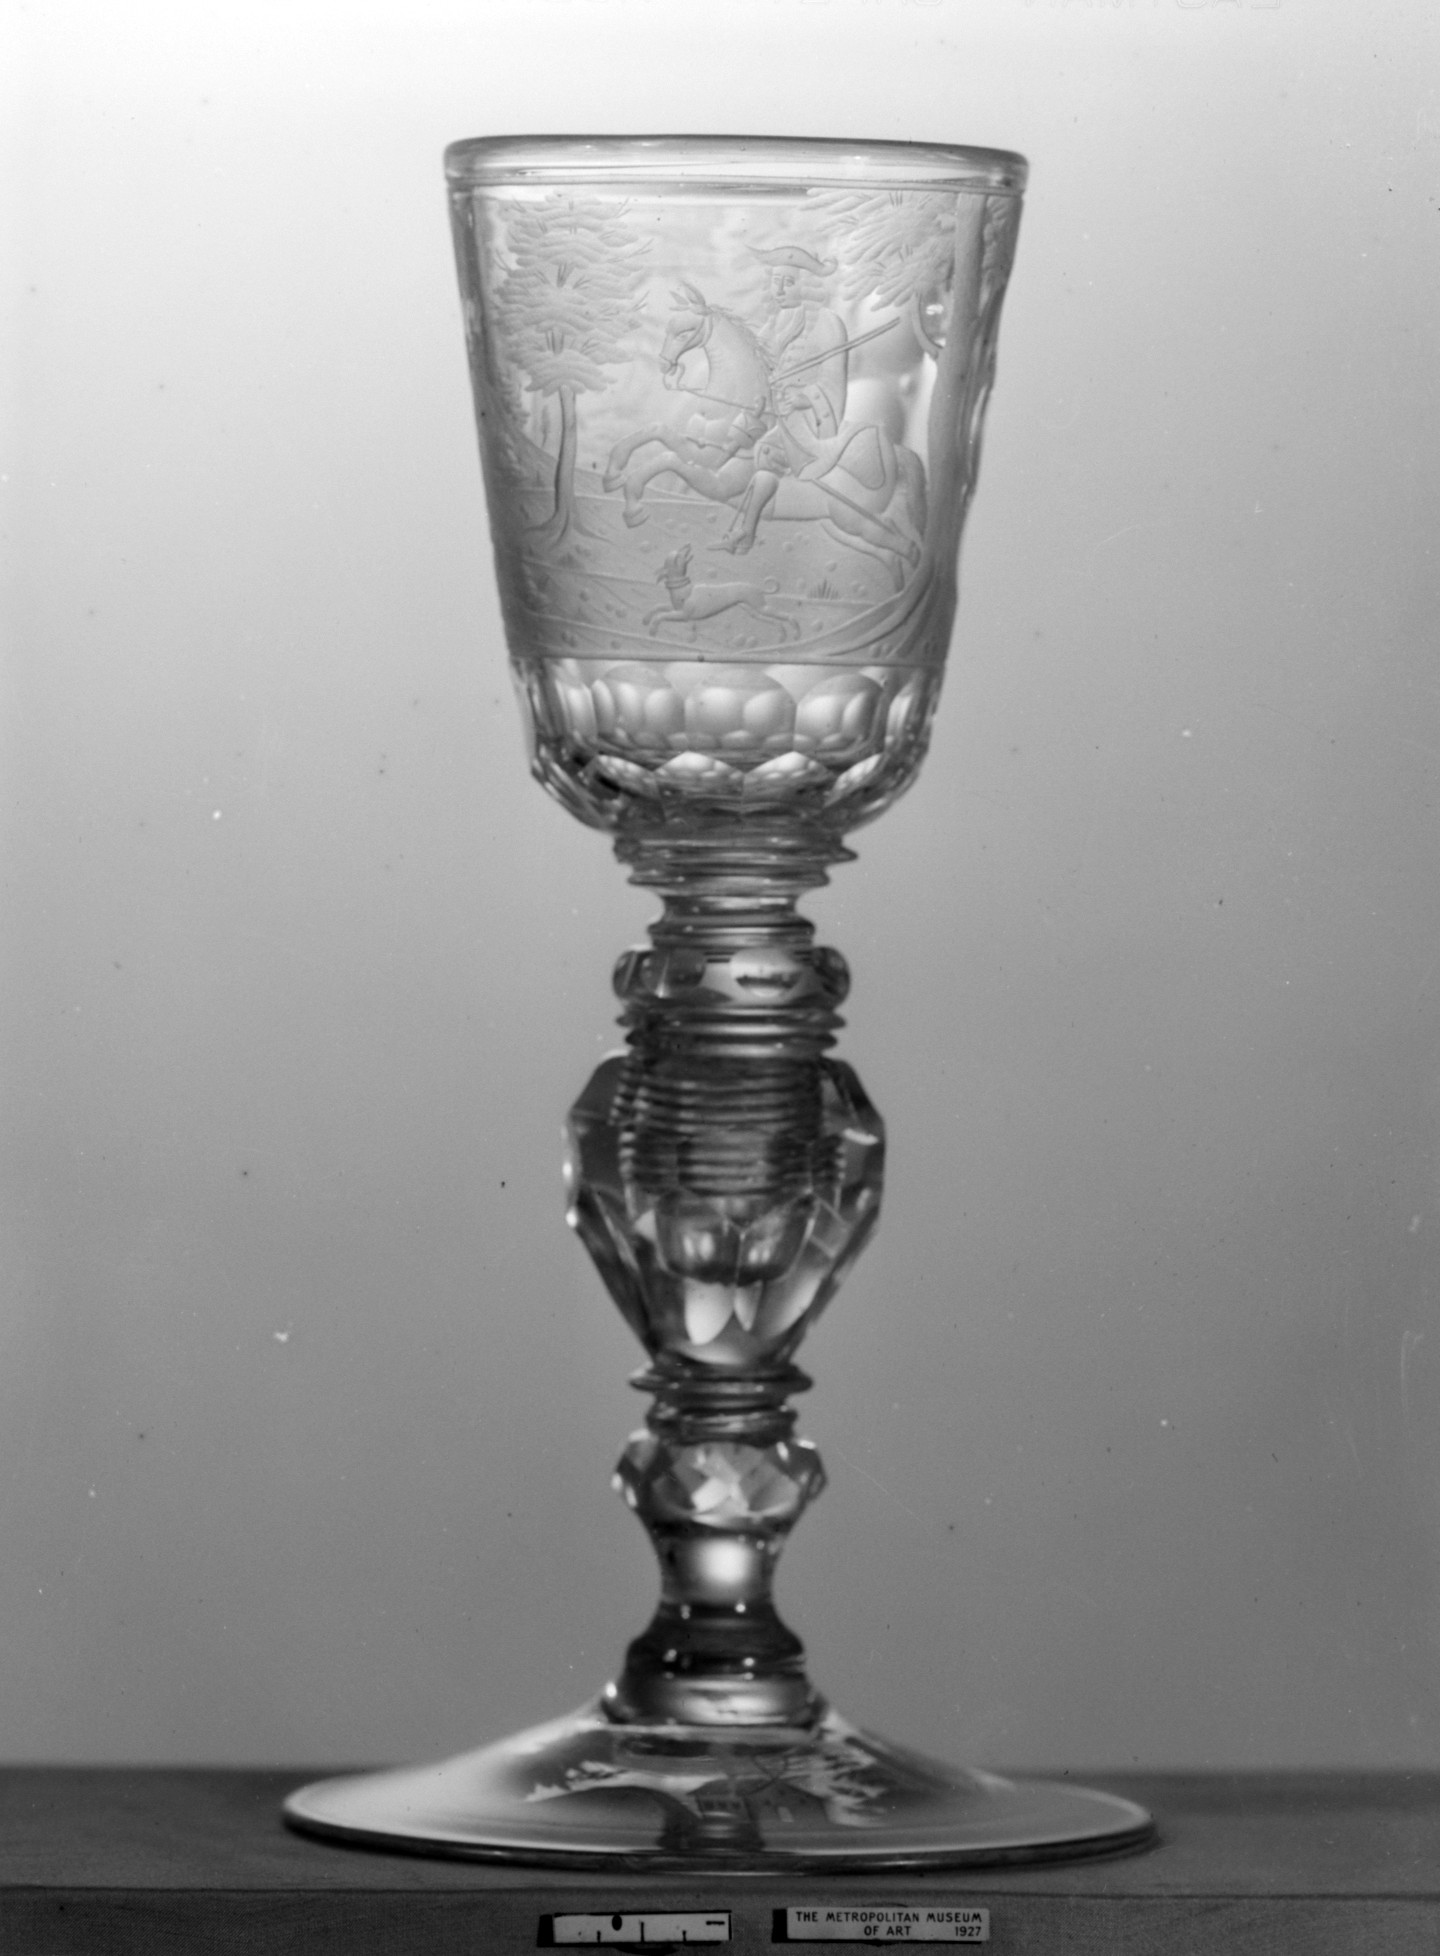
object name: standing cup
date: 1710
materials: glass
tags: men,hunting,dogs,horses